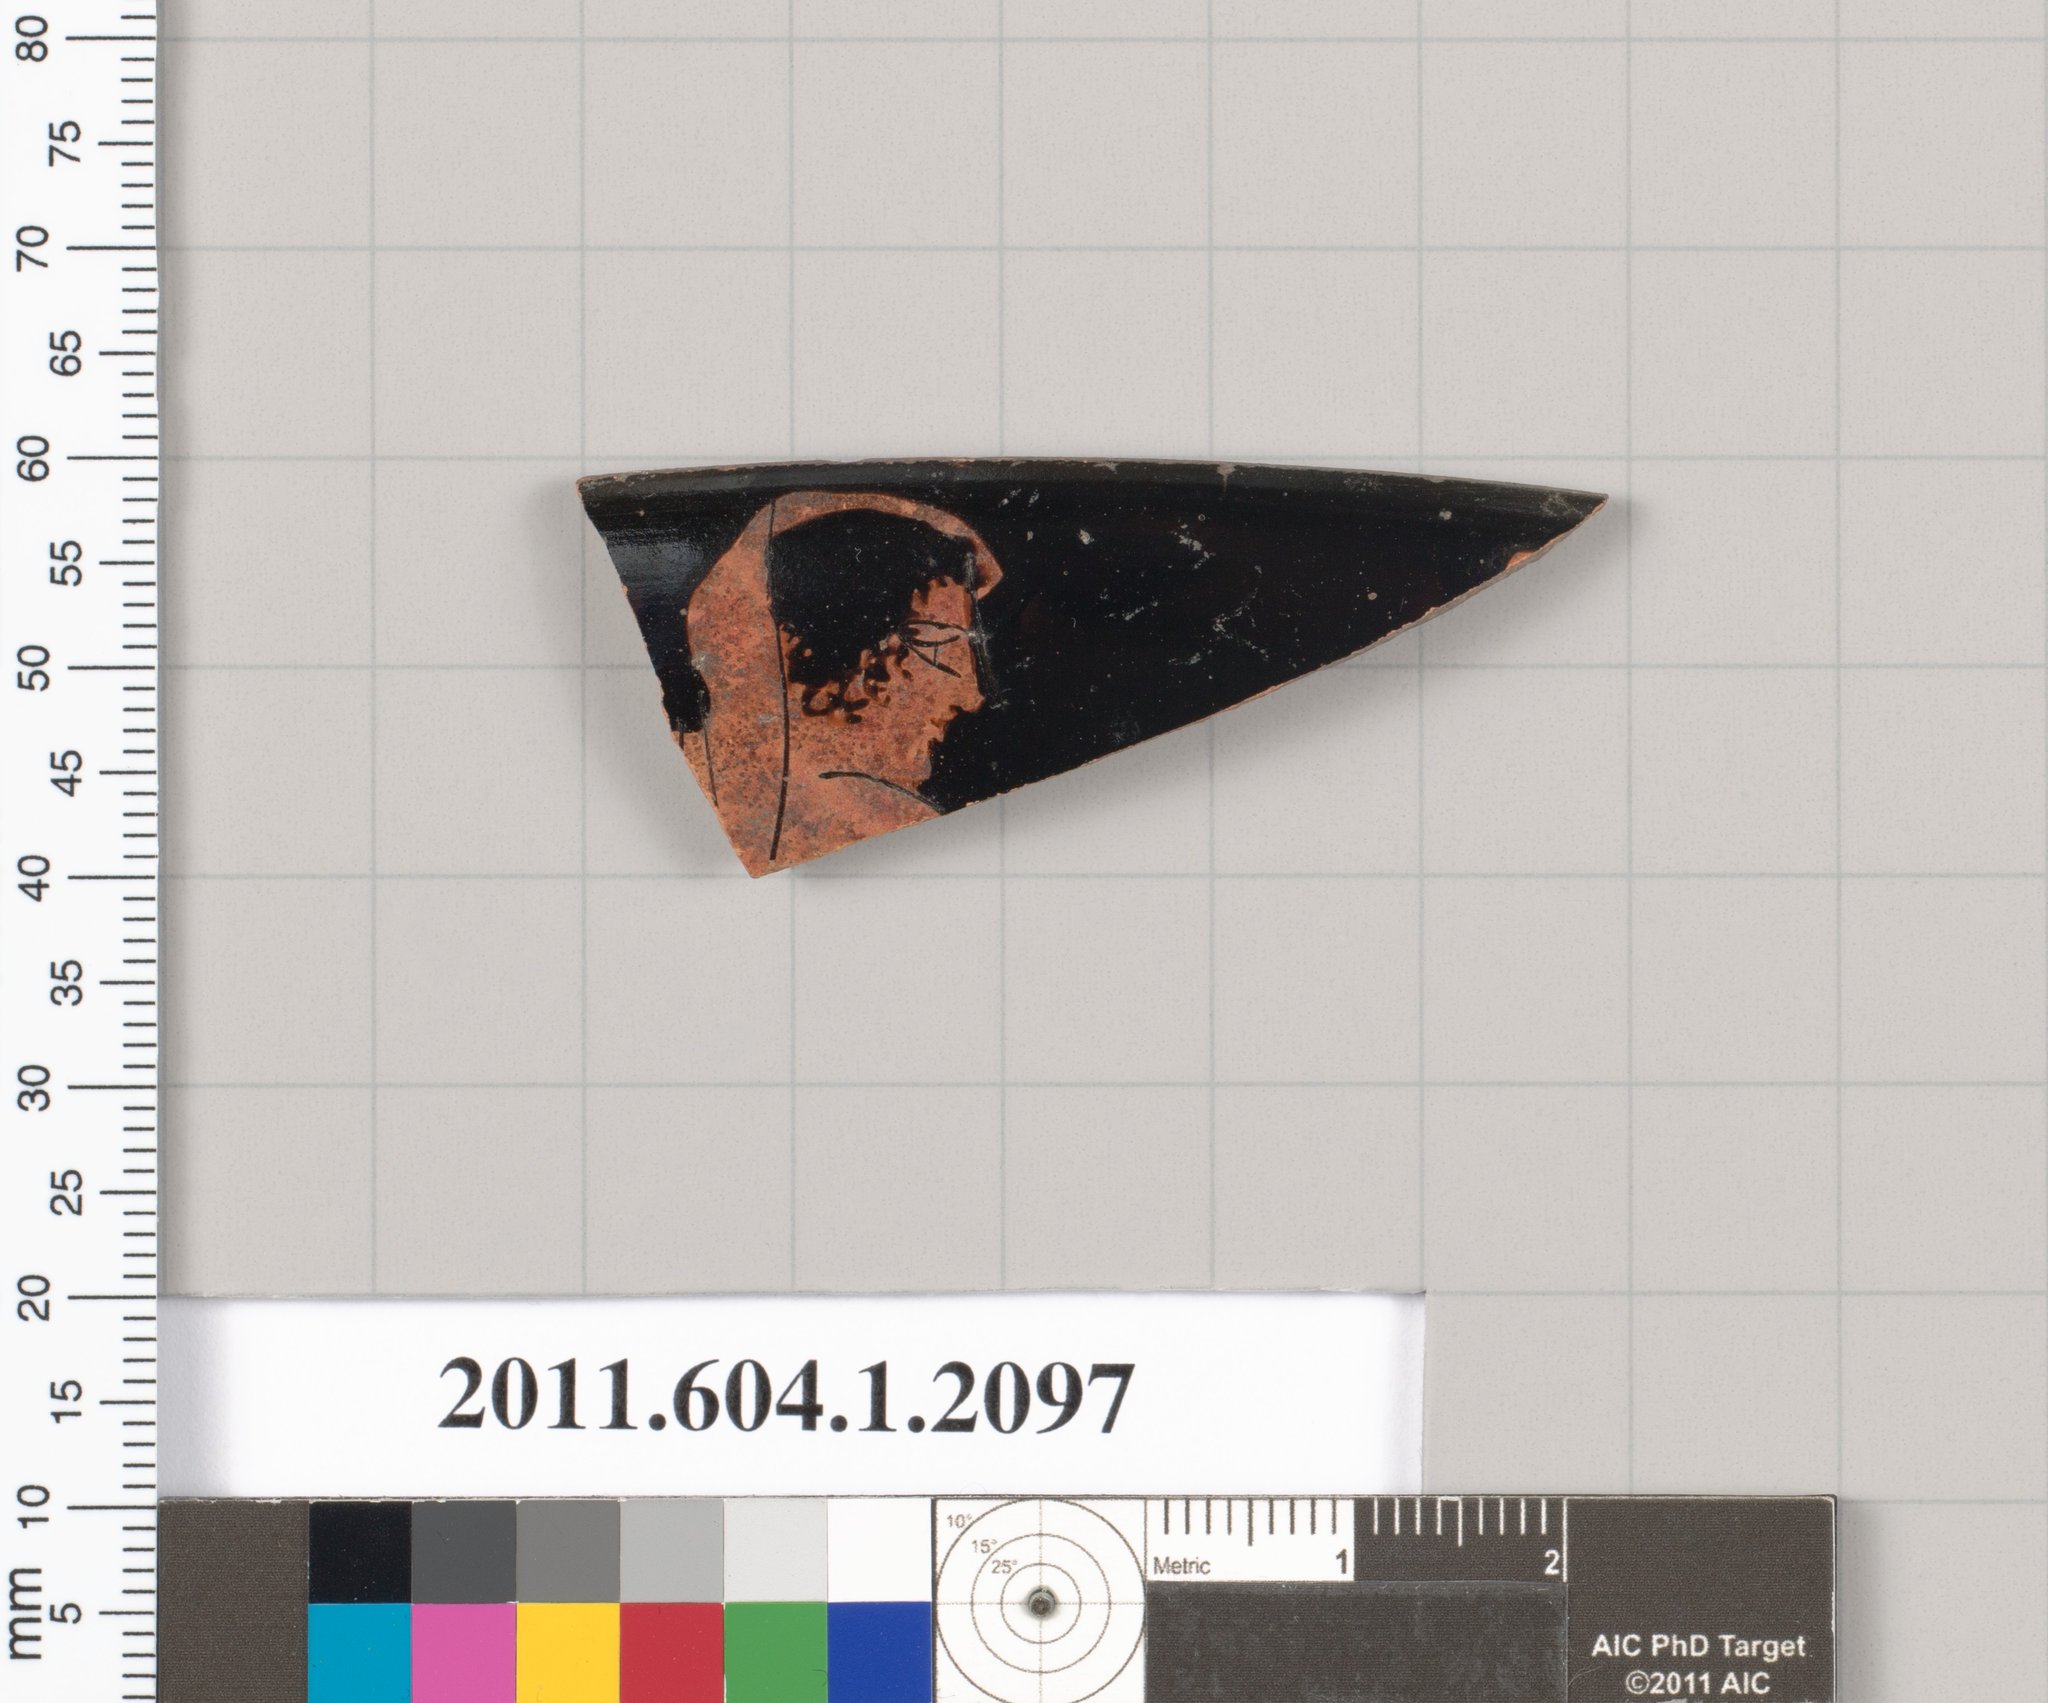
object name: kylix fragment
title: Terracotta rim fragment of a kylix (drinking cup)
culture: greek, attic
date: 467-435 BCE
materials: terracotta